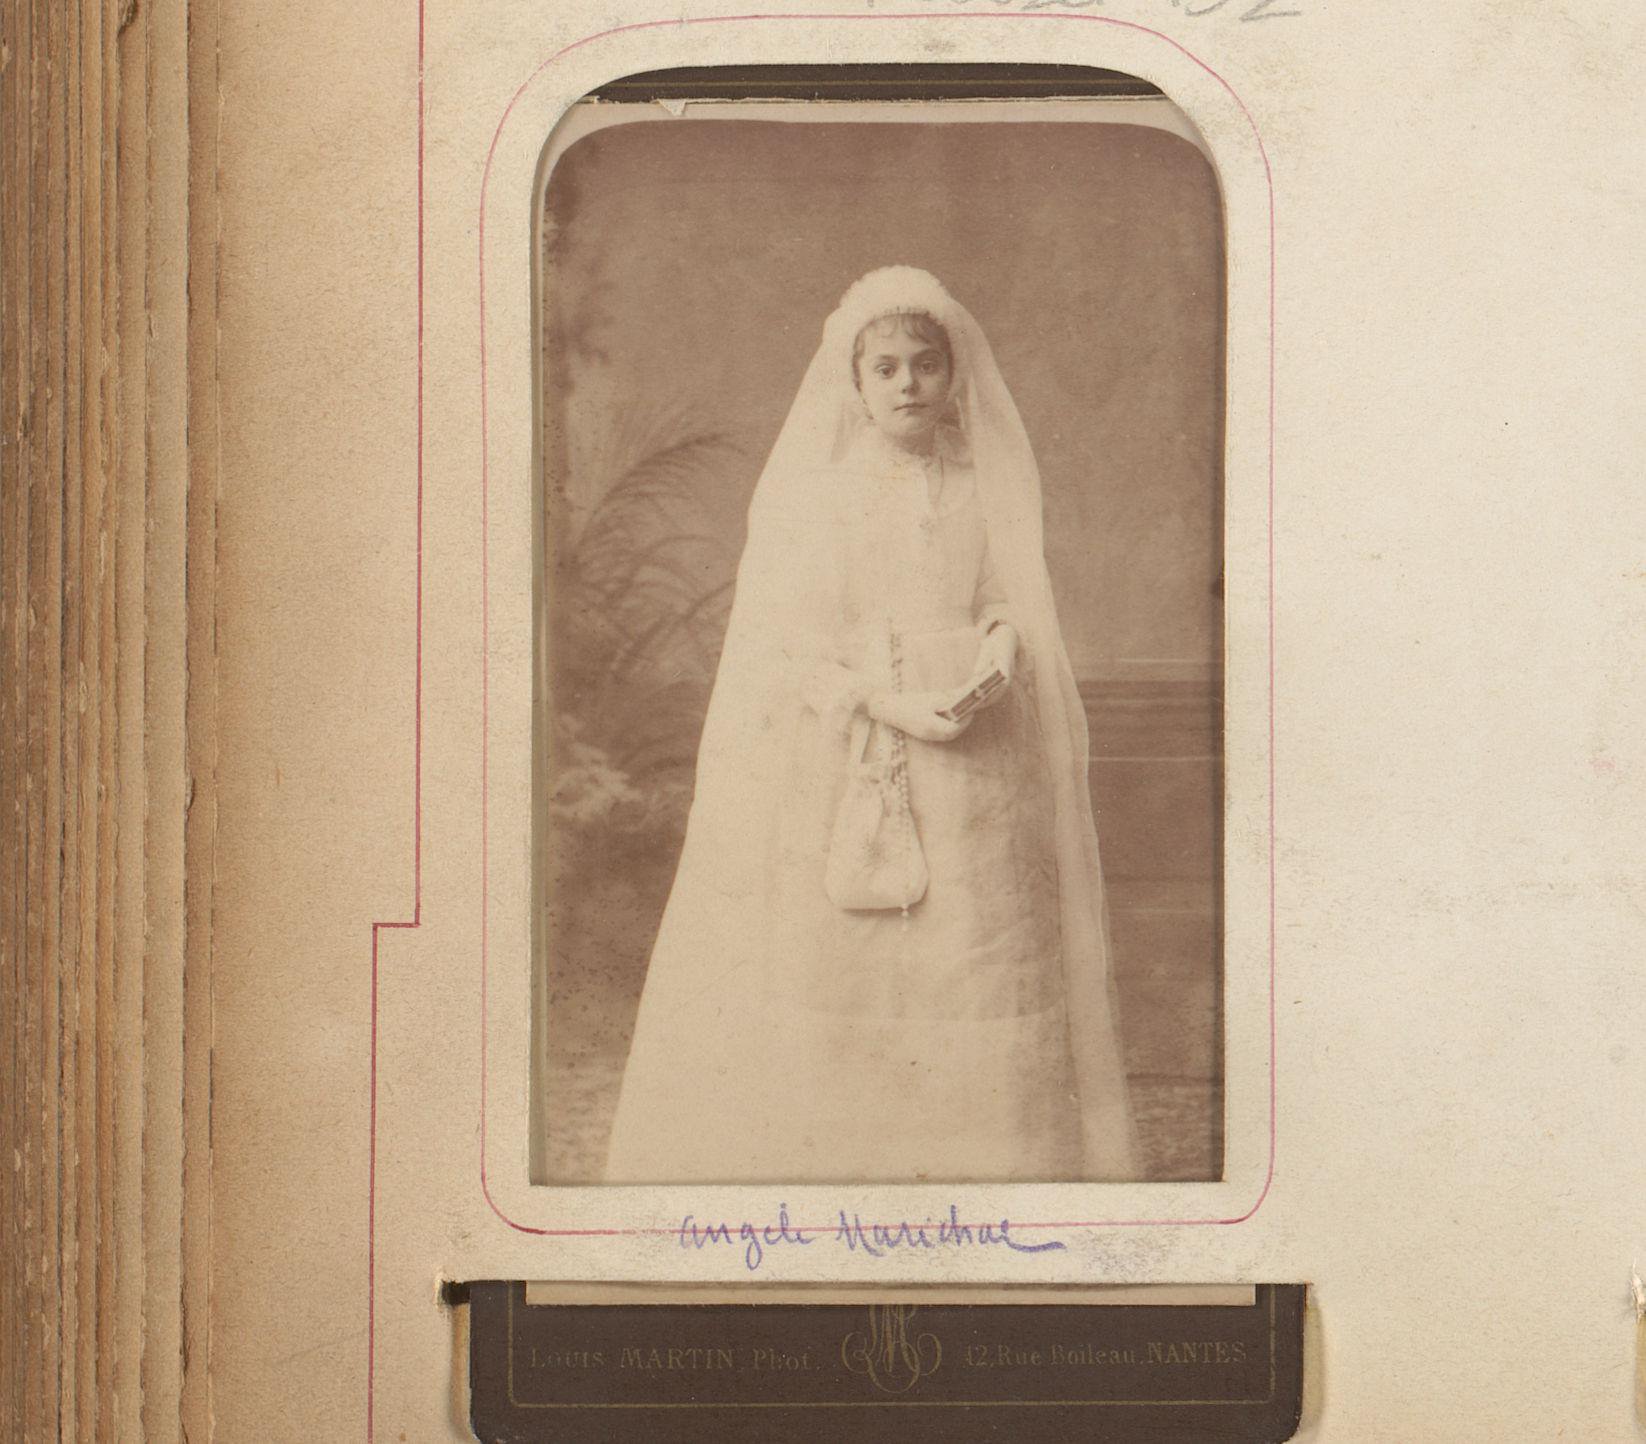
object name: photograph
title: Portret van Angéle Maréchal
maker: louis martin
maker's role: fotograaf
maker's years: -1925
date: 1870-1900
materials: cardboard, celluloid, paper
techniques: albumen print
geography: nantes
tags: historical persons, girl (child between toddler and youth)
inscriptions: inscription: ‘Les Clichés sont conservés’, address: ‘12 Rue Boileau/ NANTES’